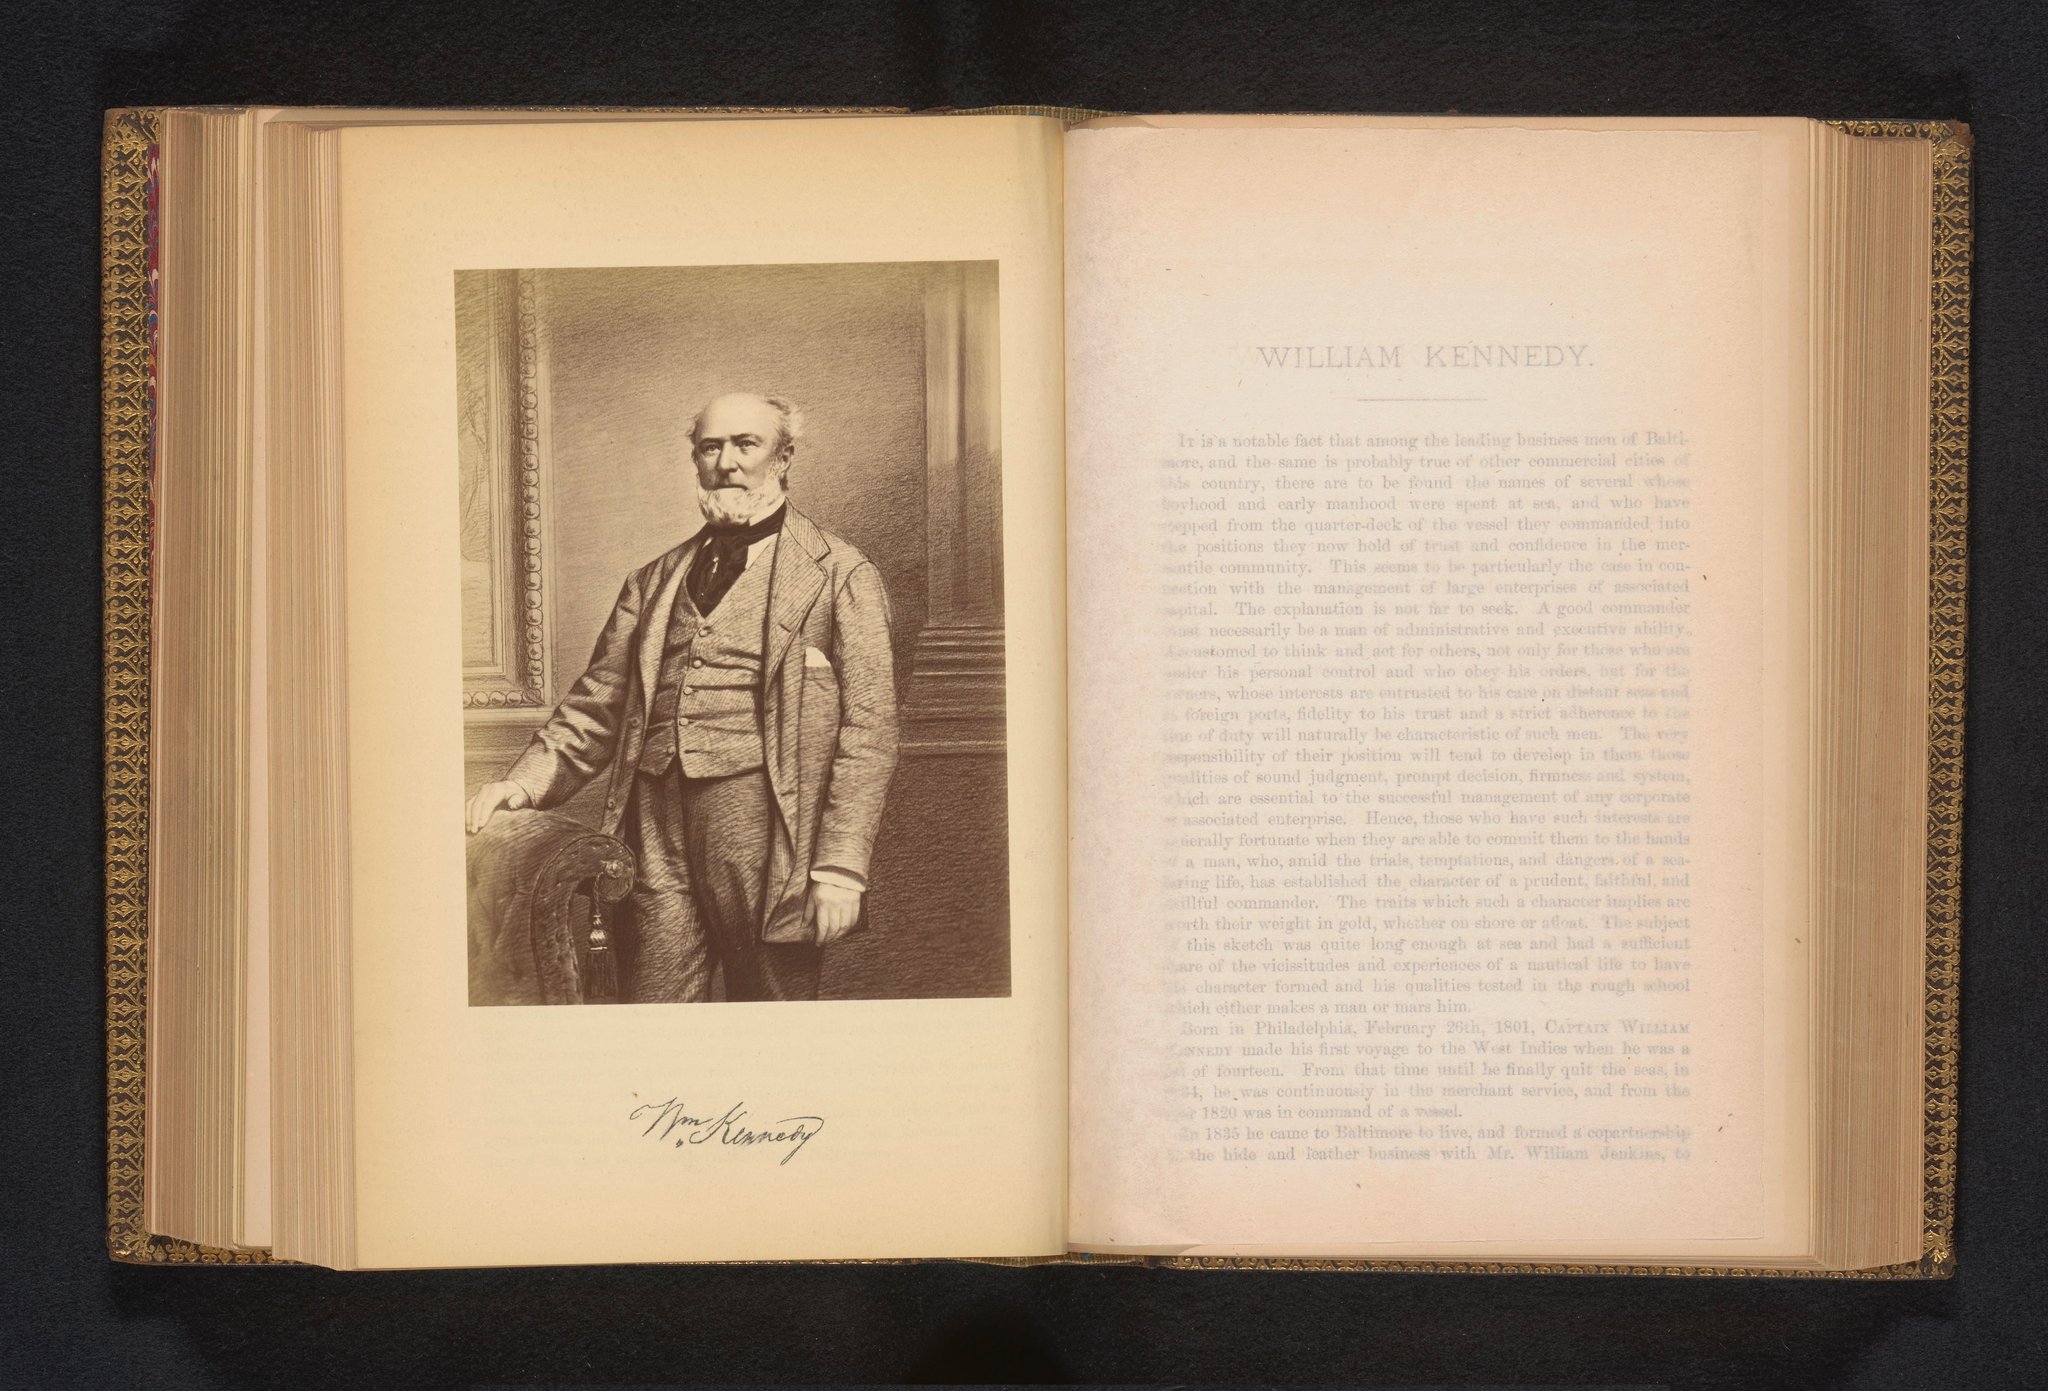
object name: reproduction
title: Fotoreproductie van een portret van William Kennedy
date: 1866-1871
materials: photographic support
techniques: albumen print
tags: historical persons